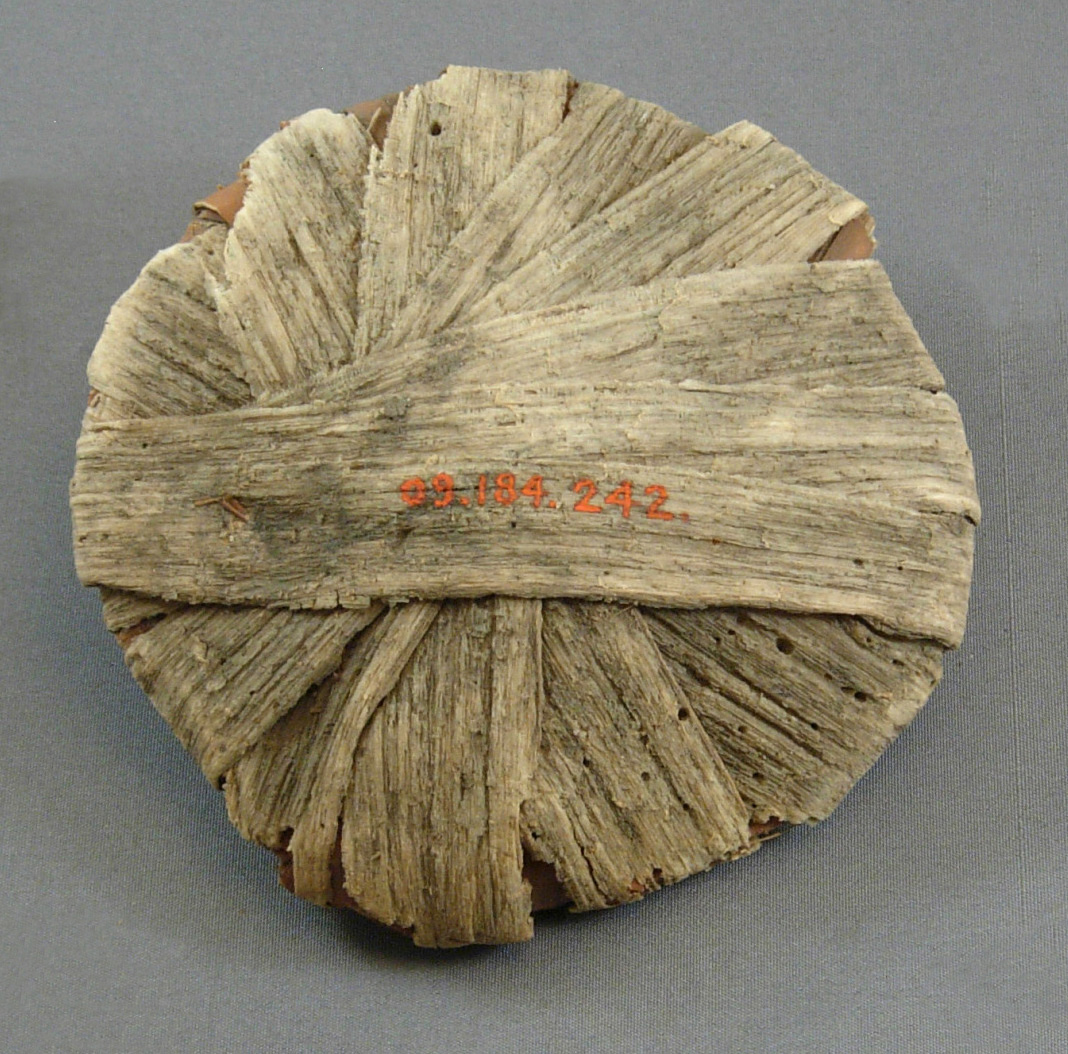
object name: jar lid, papyrus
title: Papyrus Lid from the Embalming Cache of Tutankhamun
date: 1336-1327 BCE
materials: fiber, papyrus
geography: egypt